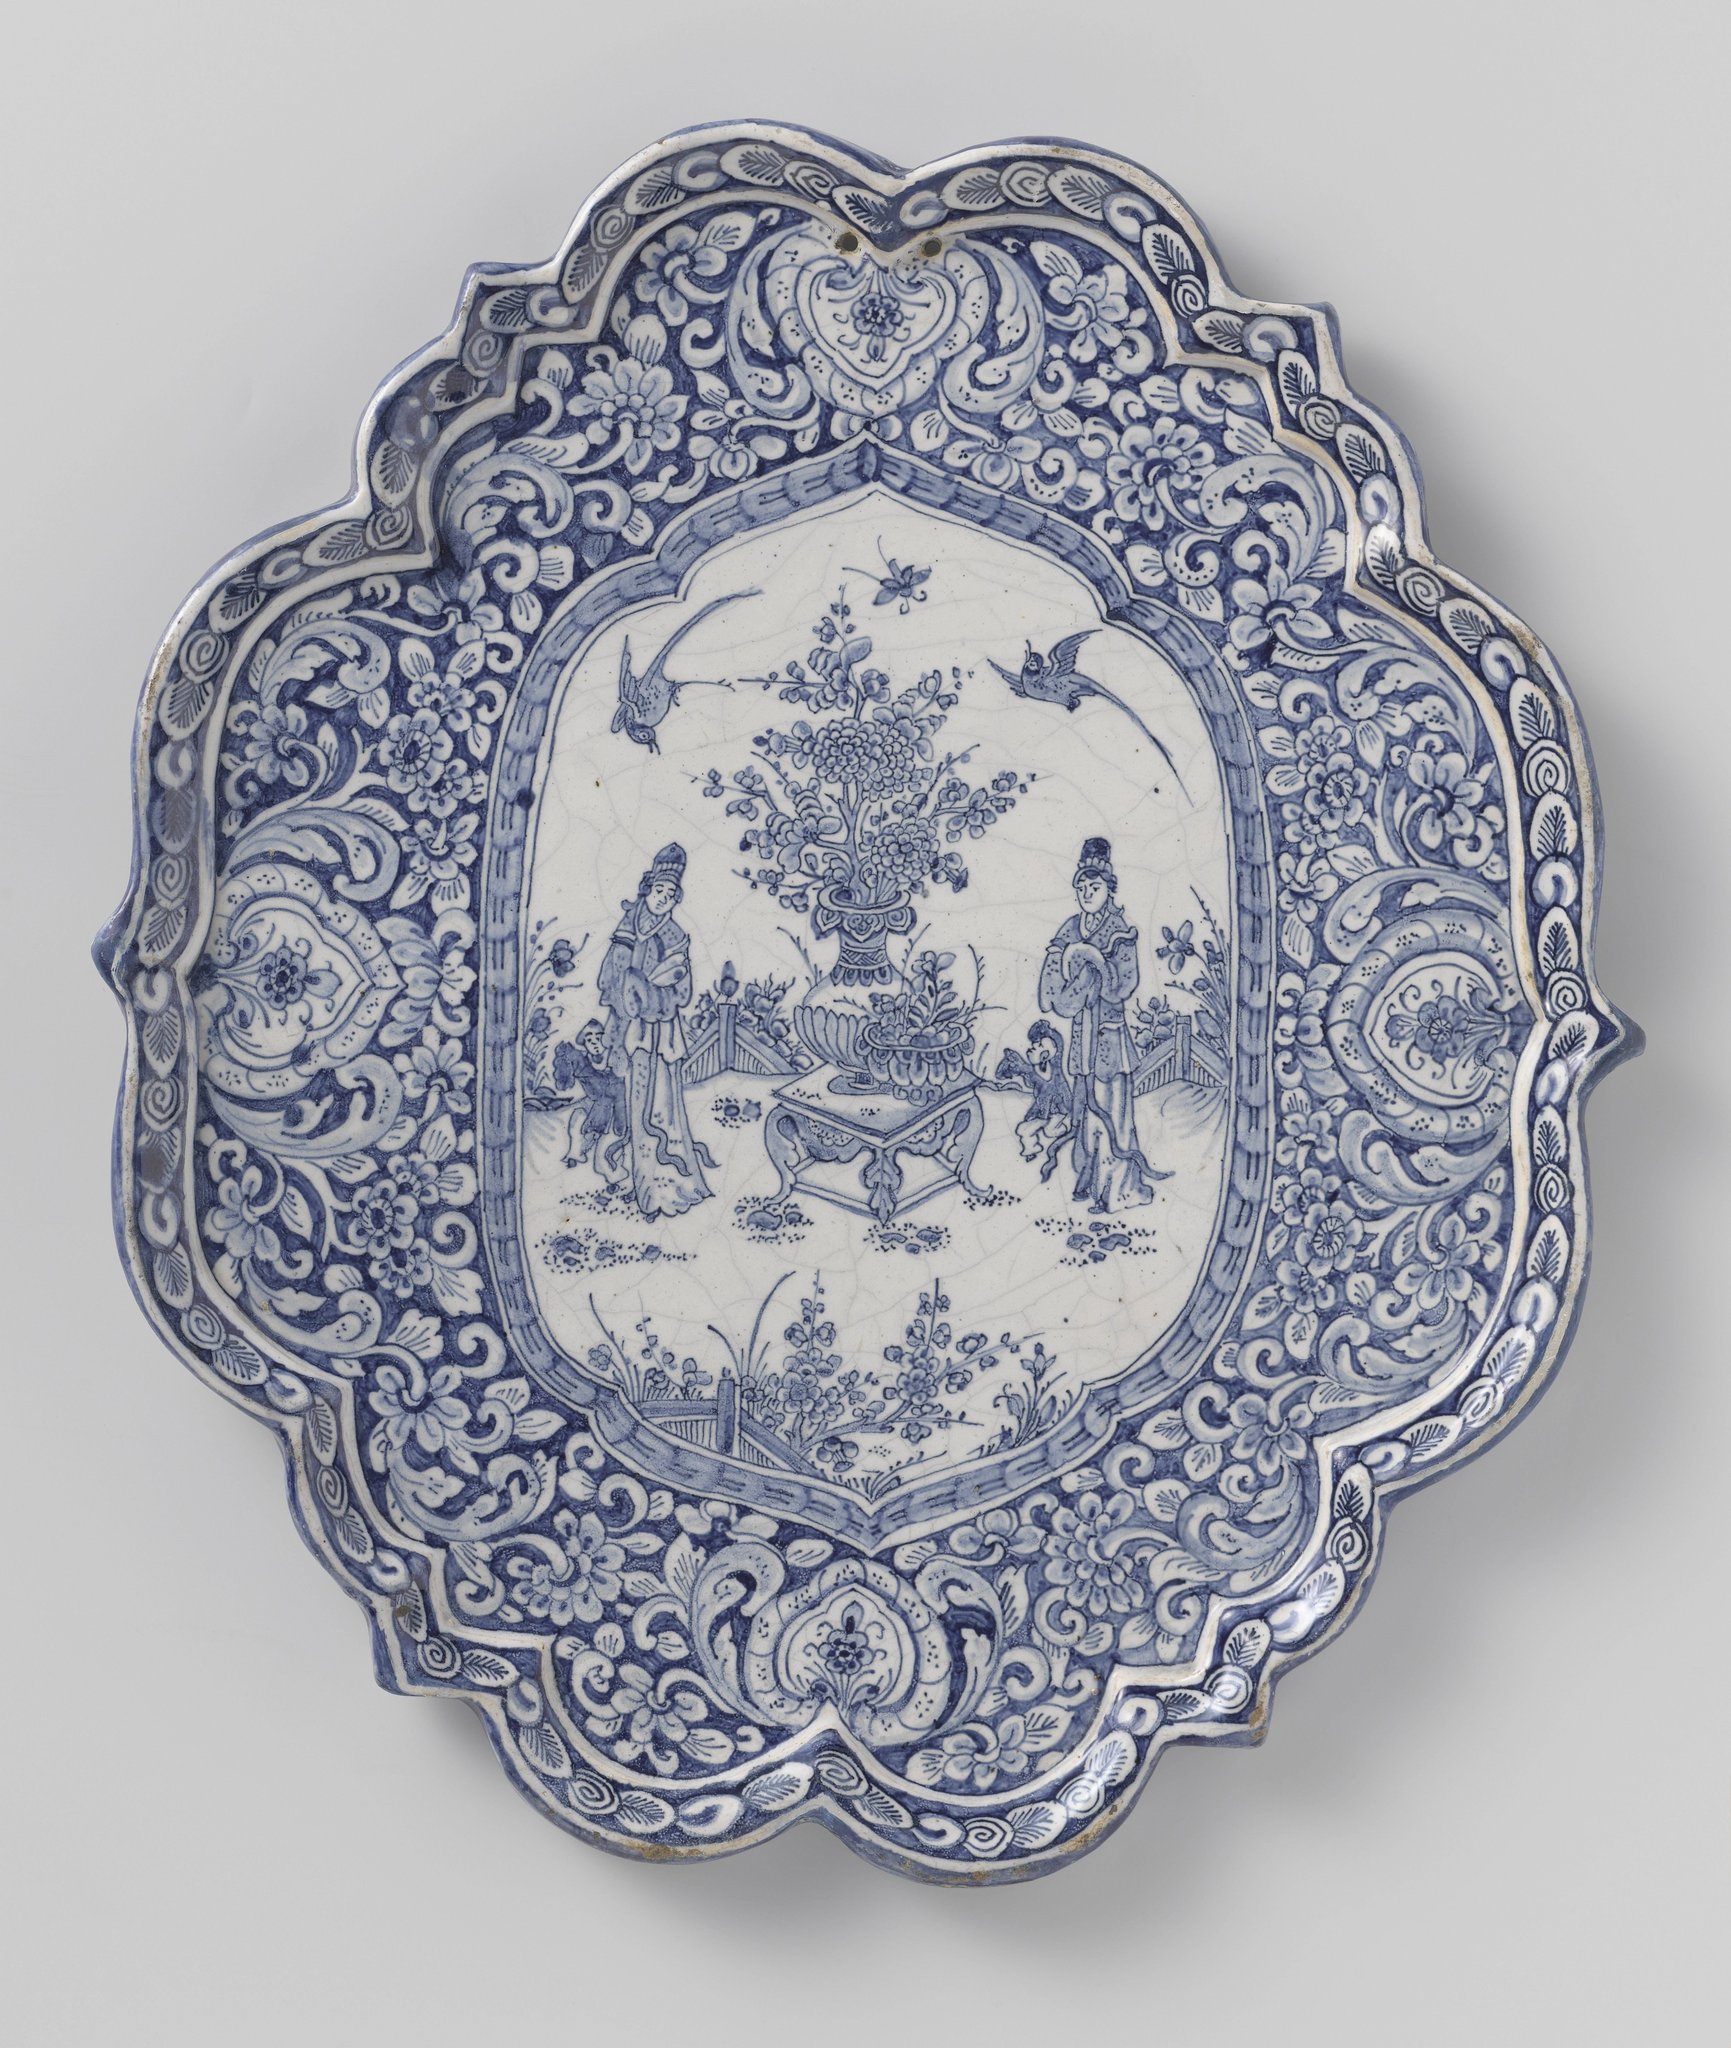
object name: plate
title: Plaat van faïence met chinoiserie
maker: Anonymous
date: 1720-1740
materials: faience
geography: delft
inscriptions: collector's mark: ‘collection J.F. Loudon’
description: Plaque van faïence met een chinoiserie decoratie.